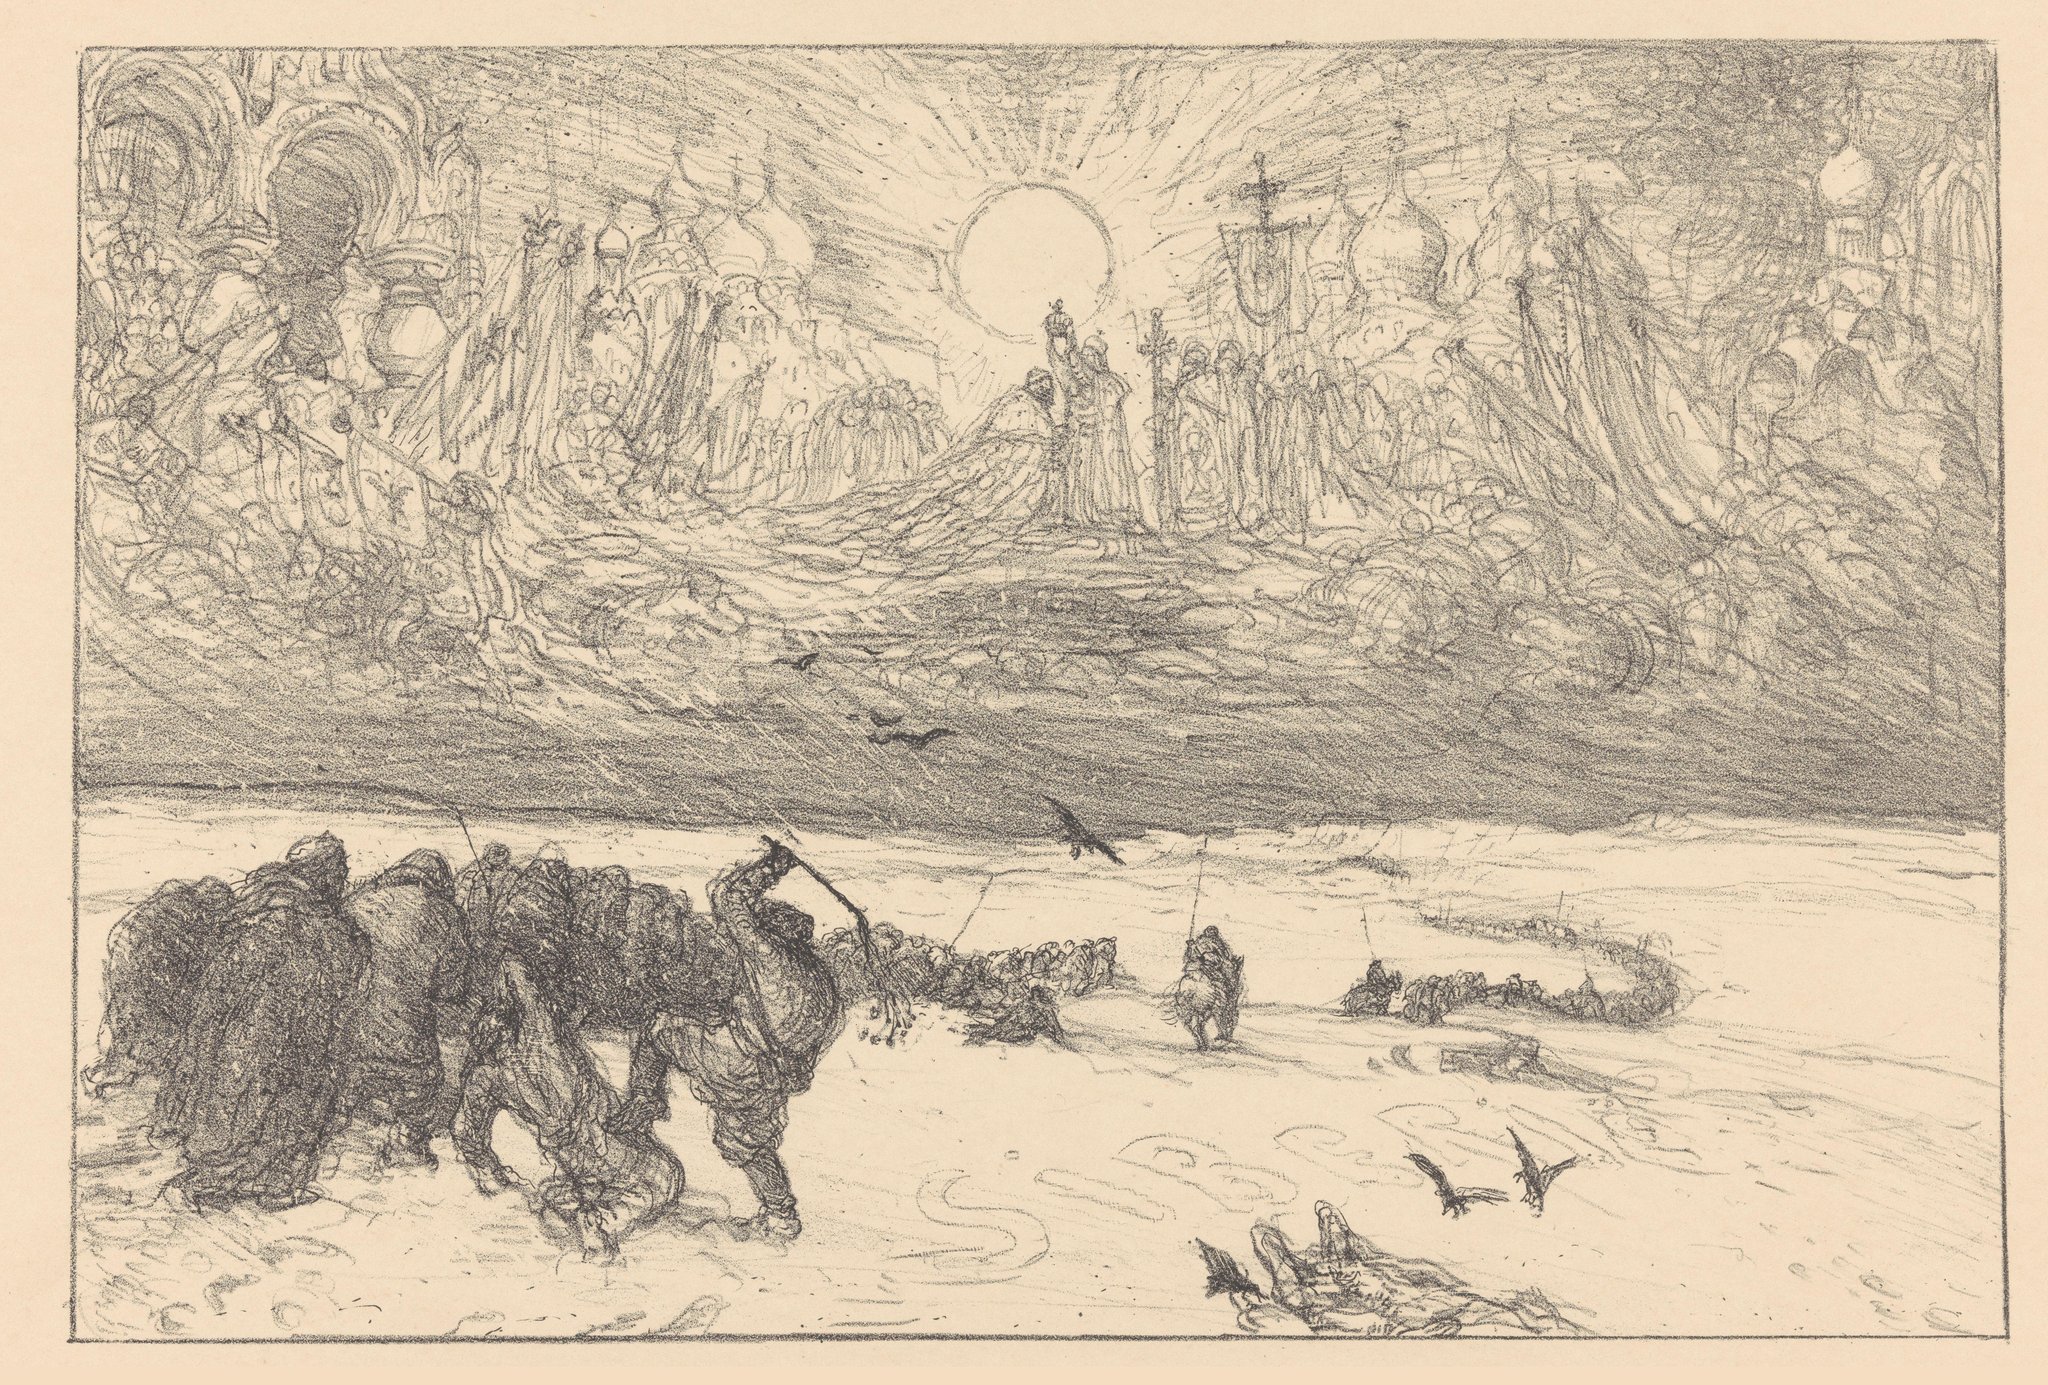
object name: print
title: De kroning van den czar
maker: marius bauer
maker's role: draughtsman, print maker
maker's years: 1867-1932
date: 1896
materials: paper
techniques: lithograph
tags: historical persons, coronation of a ruler, political caricatures and satires, russia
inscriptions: collector's mark: Lugt 2228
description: Spotprent op de tegenstelling tussen de aanstaande feestelijke kroning van tsaar Nicolaas II op 26 mei 1896 en de deportatie van politieke dissidenten naar Siberië. Een lange stoet van gevangenen wordt het besneeuwde land van Siberië ingedreven. In de lucht een weerspiegeling van de pracht en praal van de kroningsceremonie. Verschenen in het bijvoegsel van 'De Kroniek' van 8 maart 1896.